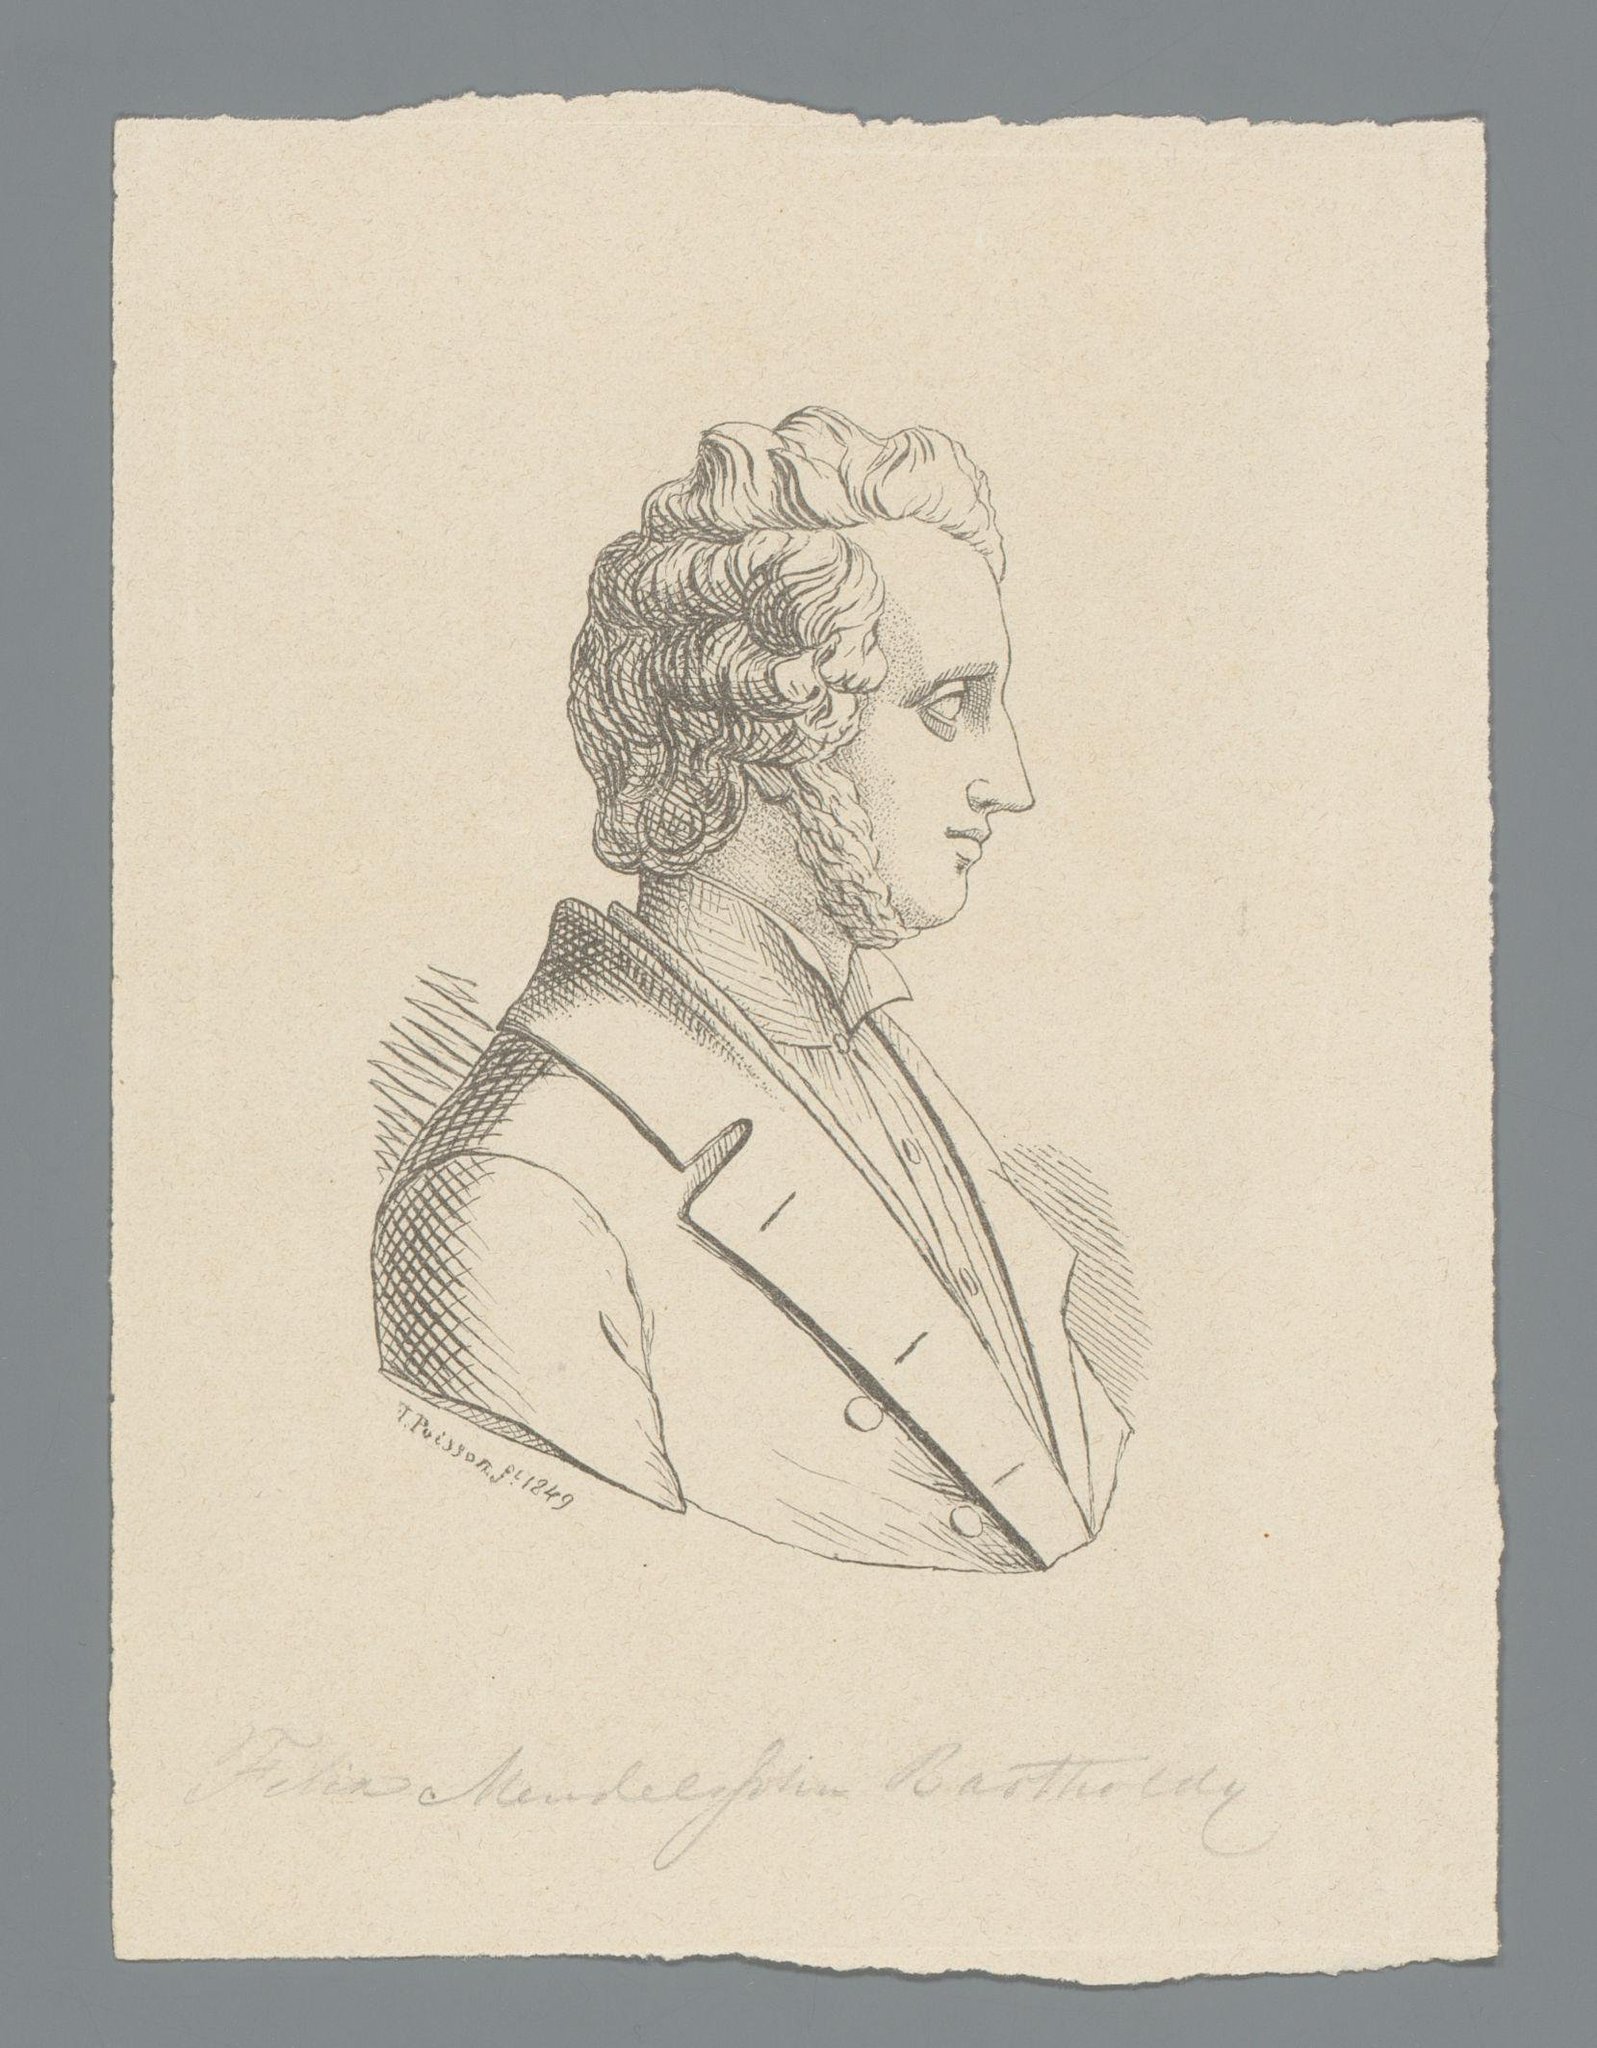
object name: print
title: Portret van onbekende man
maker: f. poisson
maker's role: print maker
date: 1849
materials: paper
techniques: lithograph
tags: historical persons not known by name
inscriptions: inscription: ‘Felix Mendelssohn Bartholdy’, collector's mark: Lugt 2228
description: Portret is mogelijk van G.L. Andersen of Felix Mendelssohn Bartholdy